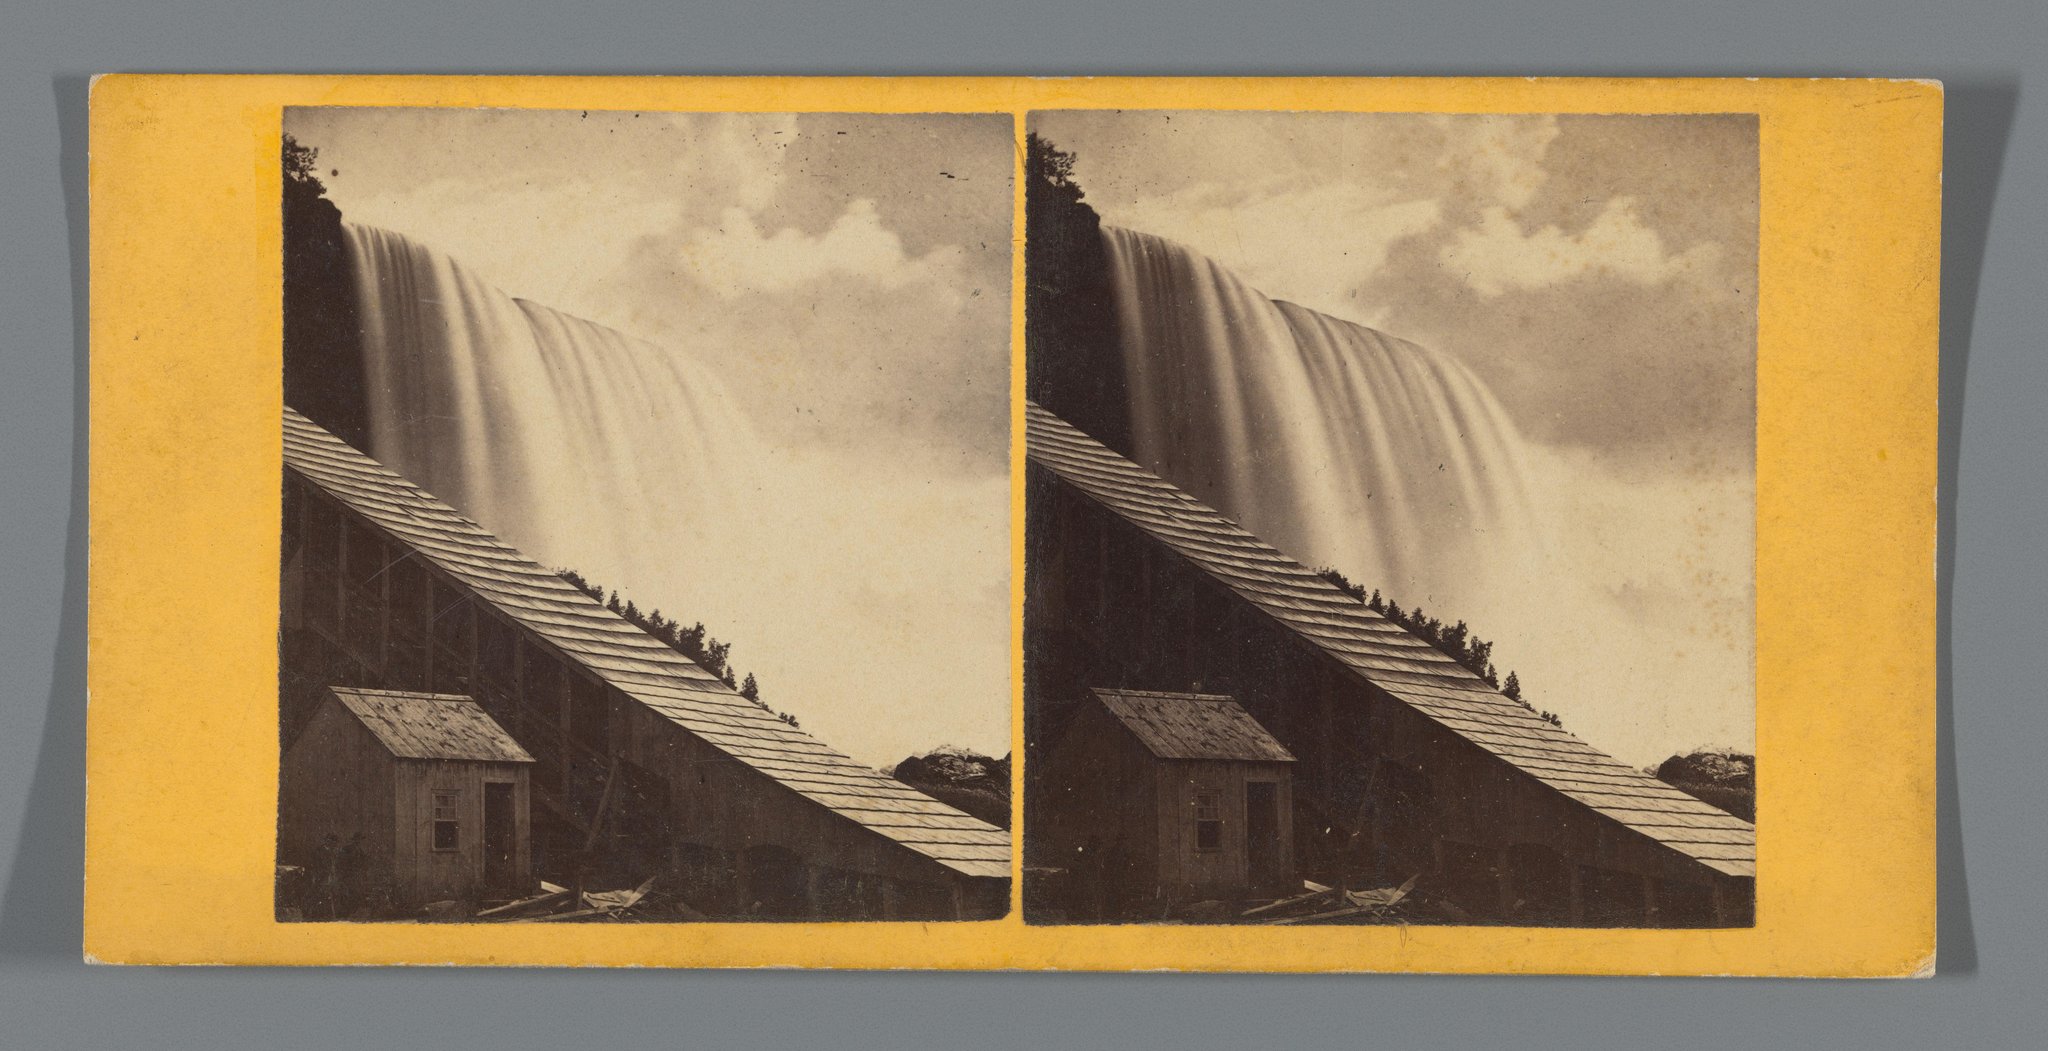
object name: photograph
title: Gezicht op de American Falls, Niagara Falls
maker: george barker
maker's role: fotograaf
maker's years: 1844-1894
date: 1865-1885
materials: cardboard, photographic support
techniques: albumen print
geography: niagara falls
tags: bridge with structure, i.e. cover or buildings, waterfall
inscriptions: inscription: ‘GEO. BARKER,/ MANUFACTURER OF/ GLASS & PAPER STEREOSCOPIC VIEWS/ NIAGARA FALLS, N.Y.’, inscription: ‘American Fall’